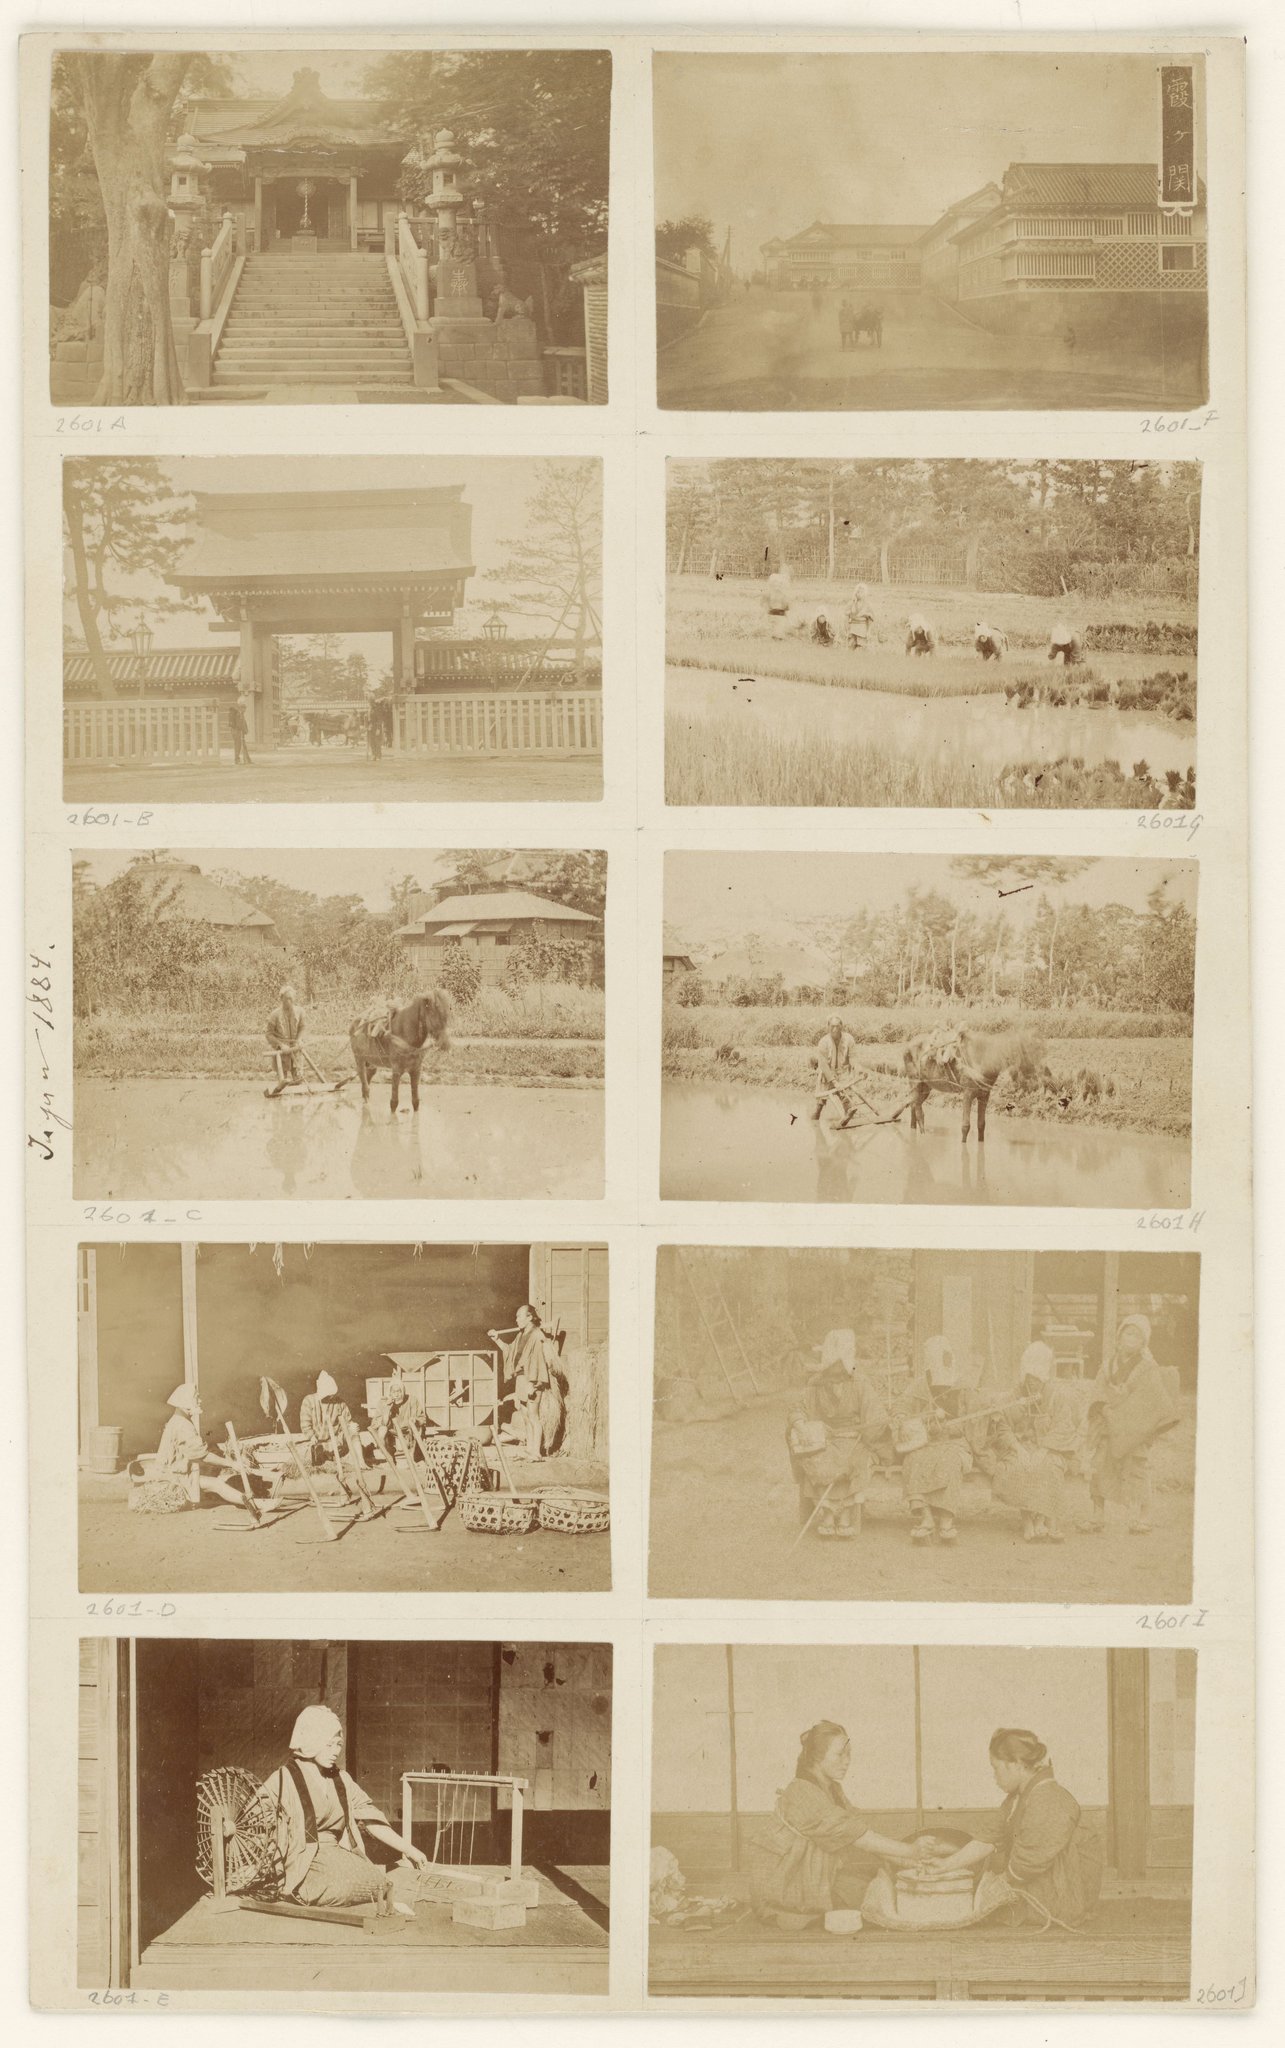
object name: photograph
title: Landarbeiders aan het werk in een rijstveld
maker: Anonymous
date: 1884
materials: cardboard, paper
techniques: albumen print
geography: japan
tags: harvest, sawahs, rice paddies, japan